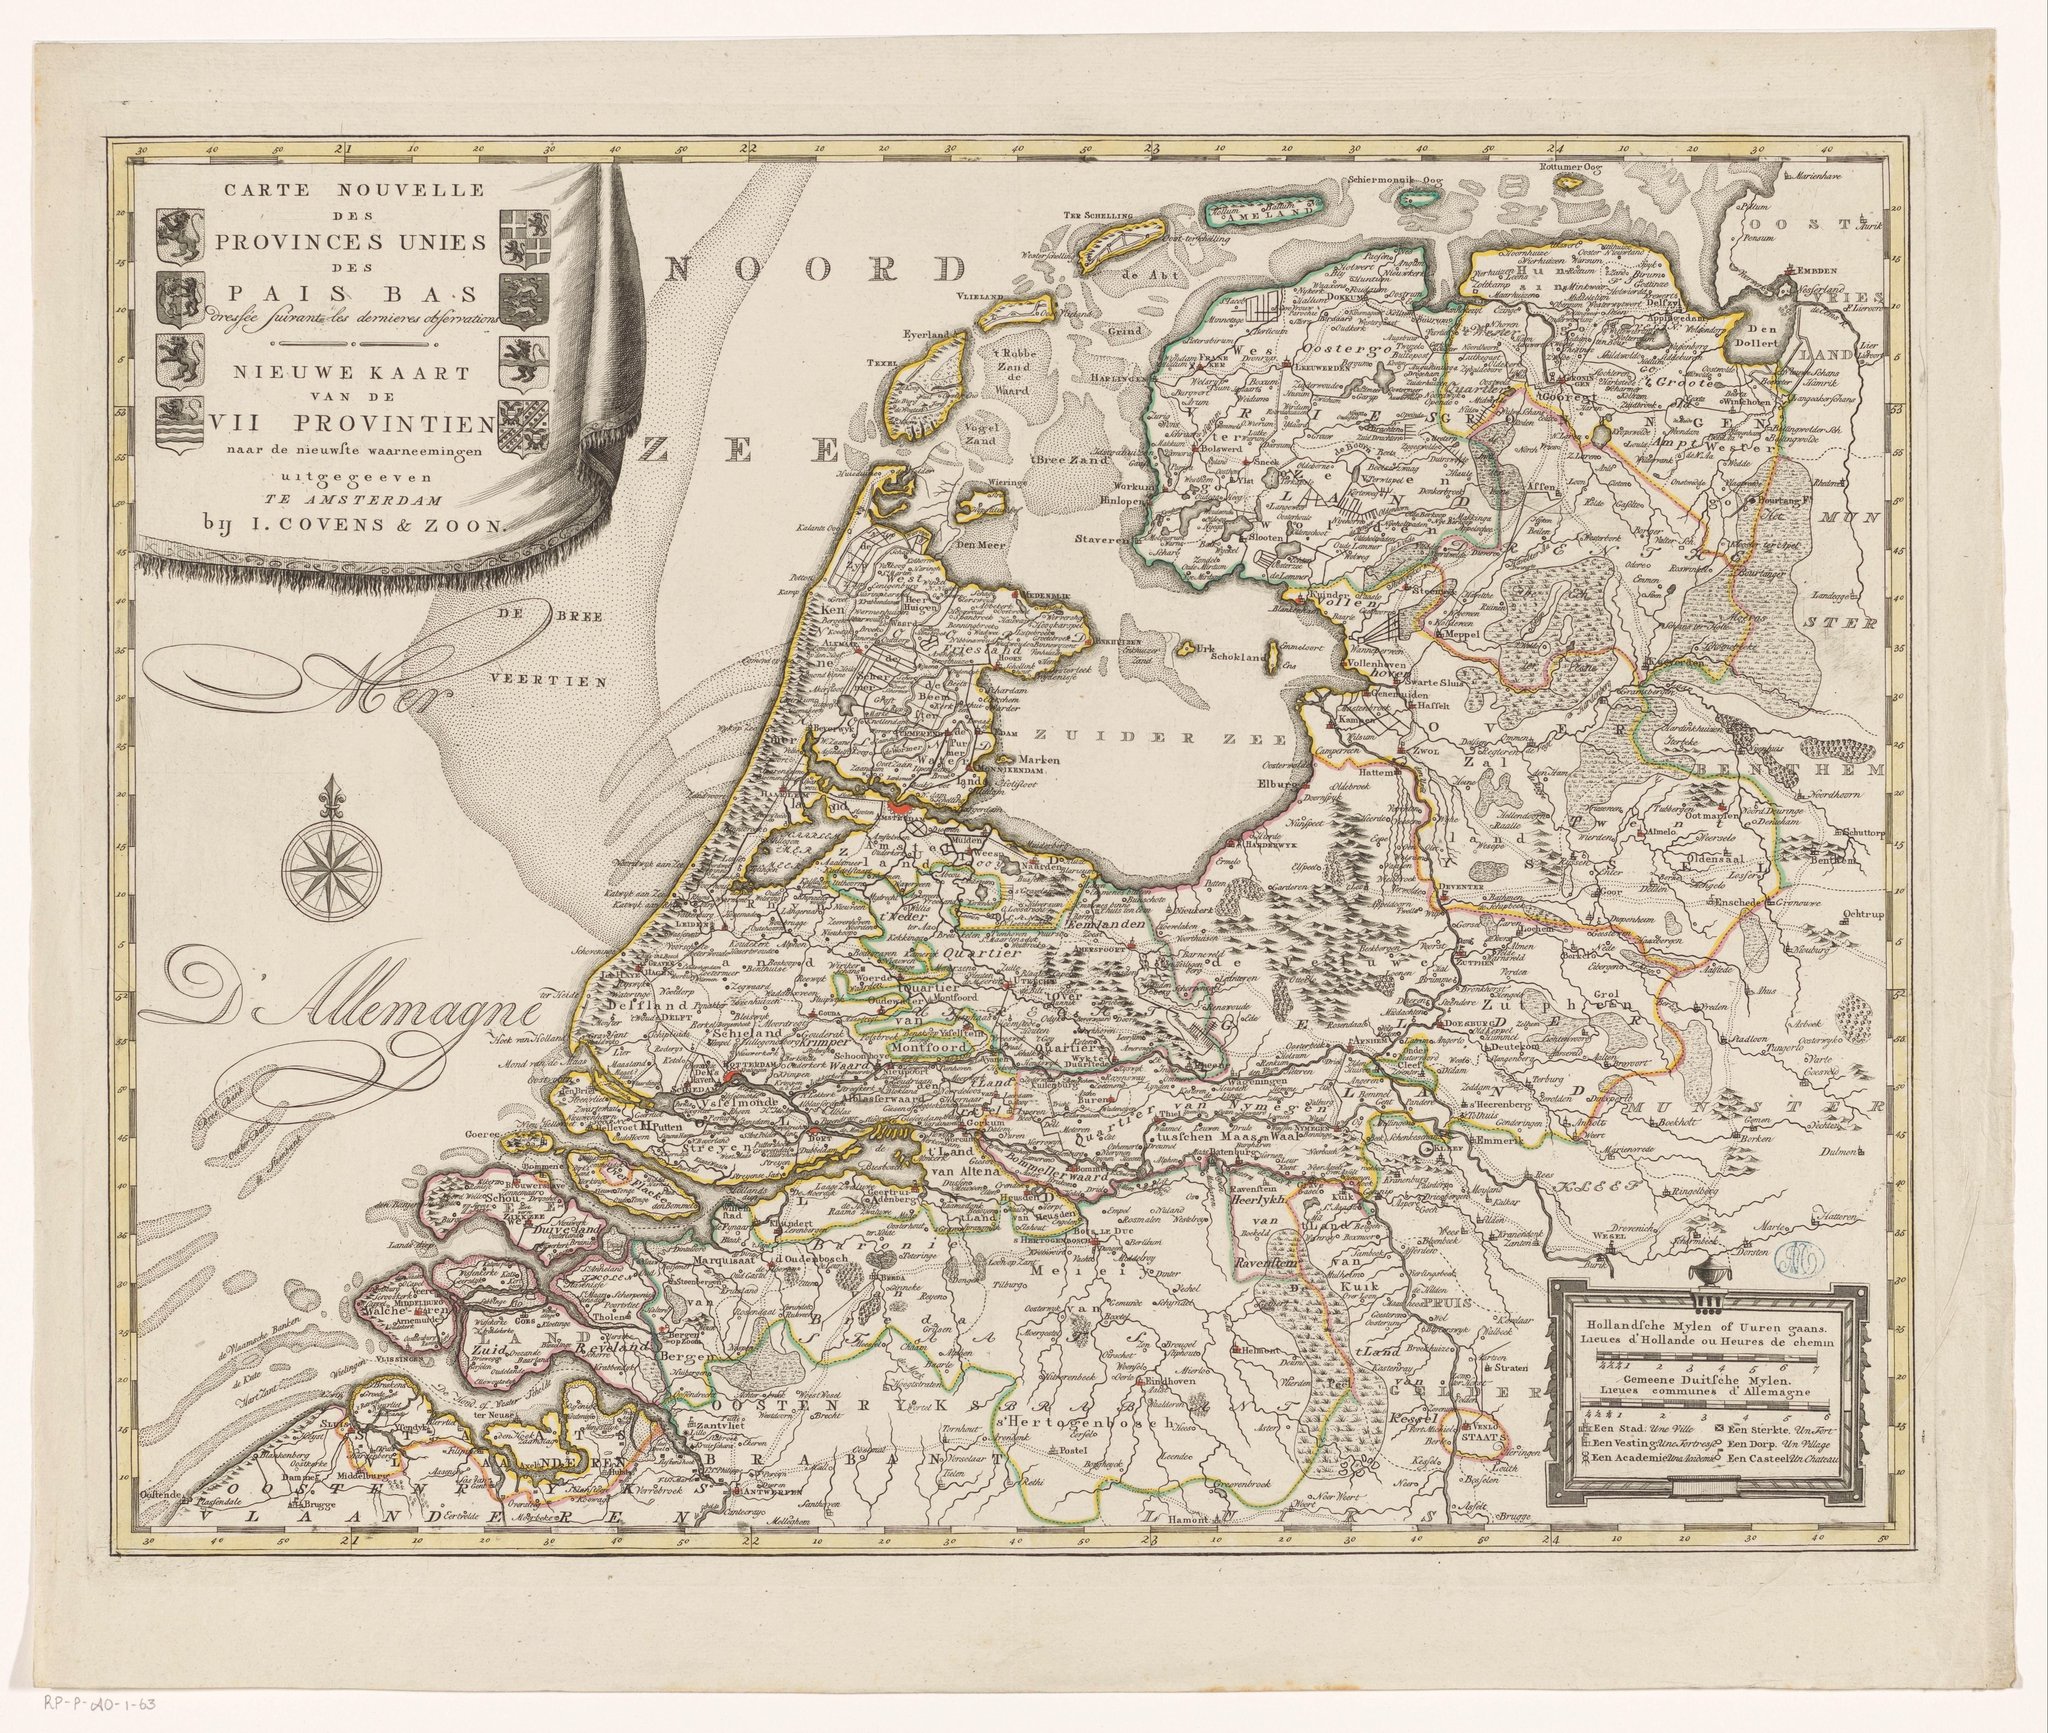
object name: map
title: Kaart van de Republiek der Zeven Verenigde Nederlanden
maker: Anonymous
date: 1787-1792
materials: paper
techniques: engraving, etching, hand coloring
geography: amsterdam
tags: coat of arms (as symbol of the state, etc.), maps of separate countries or regions, netherlands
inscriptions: collector's mark: Briquet 2228, collector's mark: Lugt 195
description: Linksboven cartouche met Franse en Nederlandse titel en de wapens van de Republiek en de Zeven Provinciën. Rechtsonder cartouche met legenda en schaalstok: Hollandsche mylen of uuren gaans / Lieues d'Hollande ou heures de chemin, Gemeene Duitsche mylen / Lieues communes d'Allemagne. Gradenverdeling langs de randen.